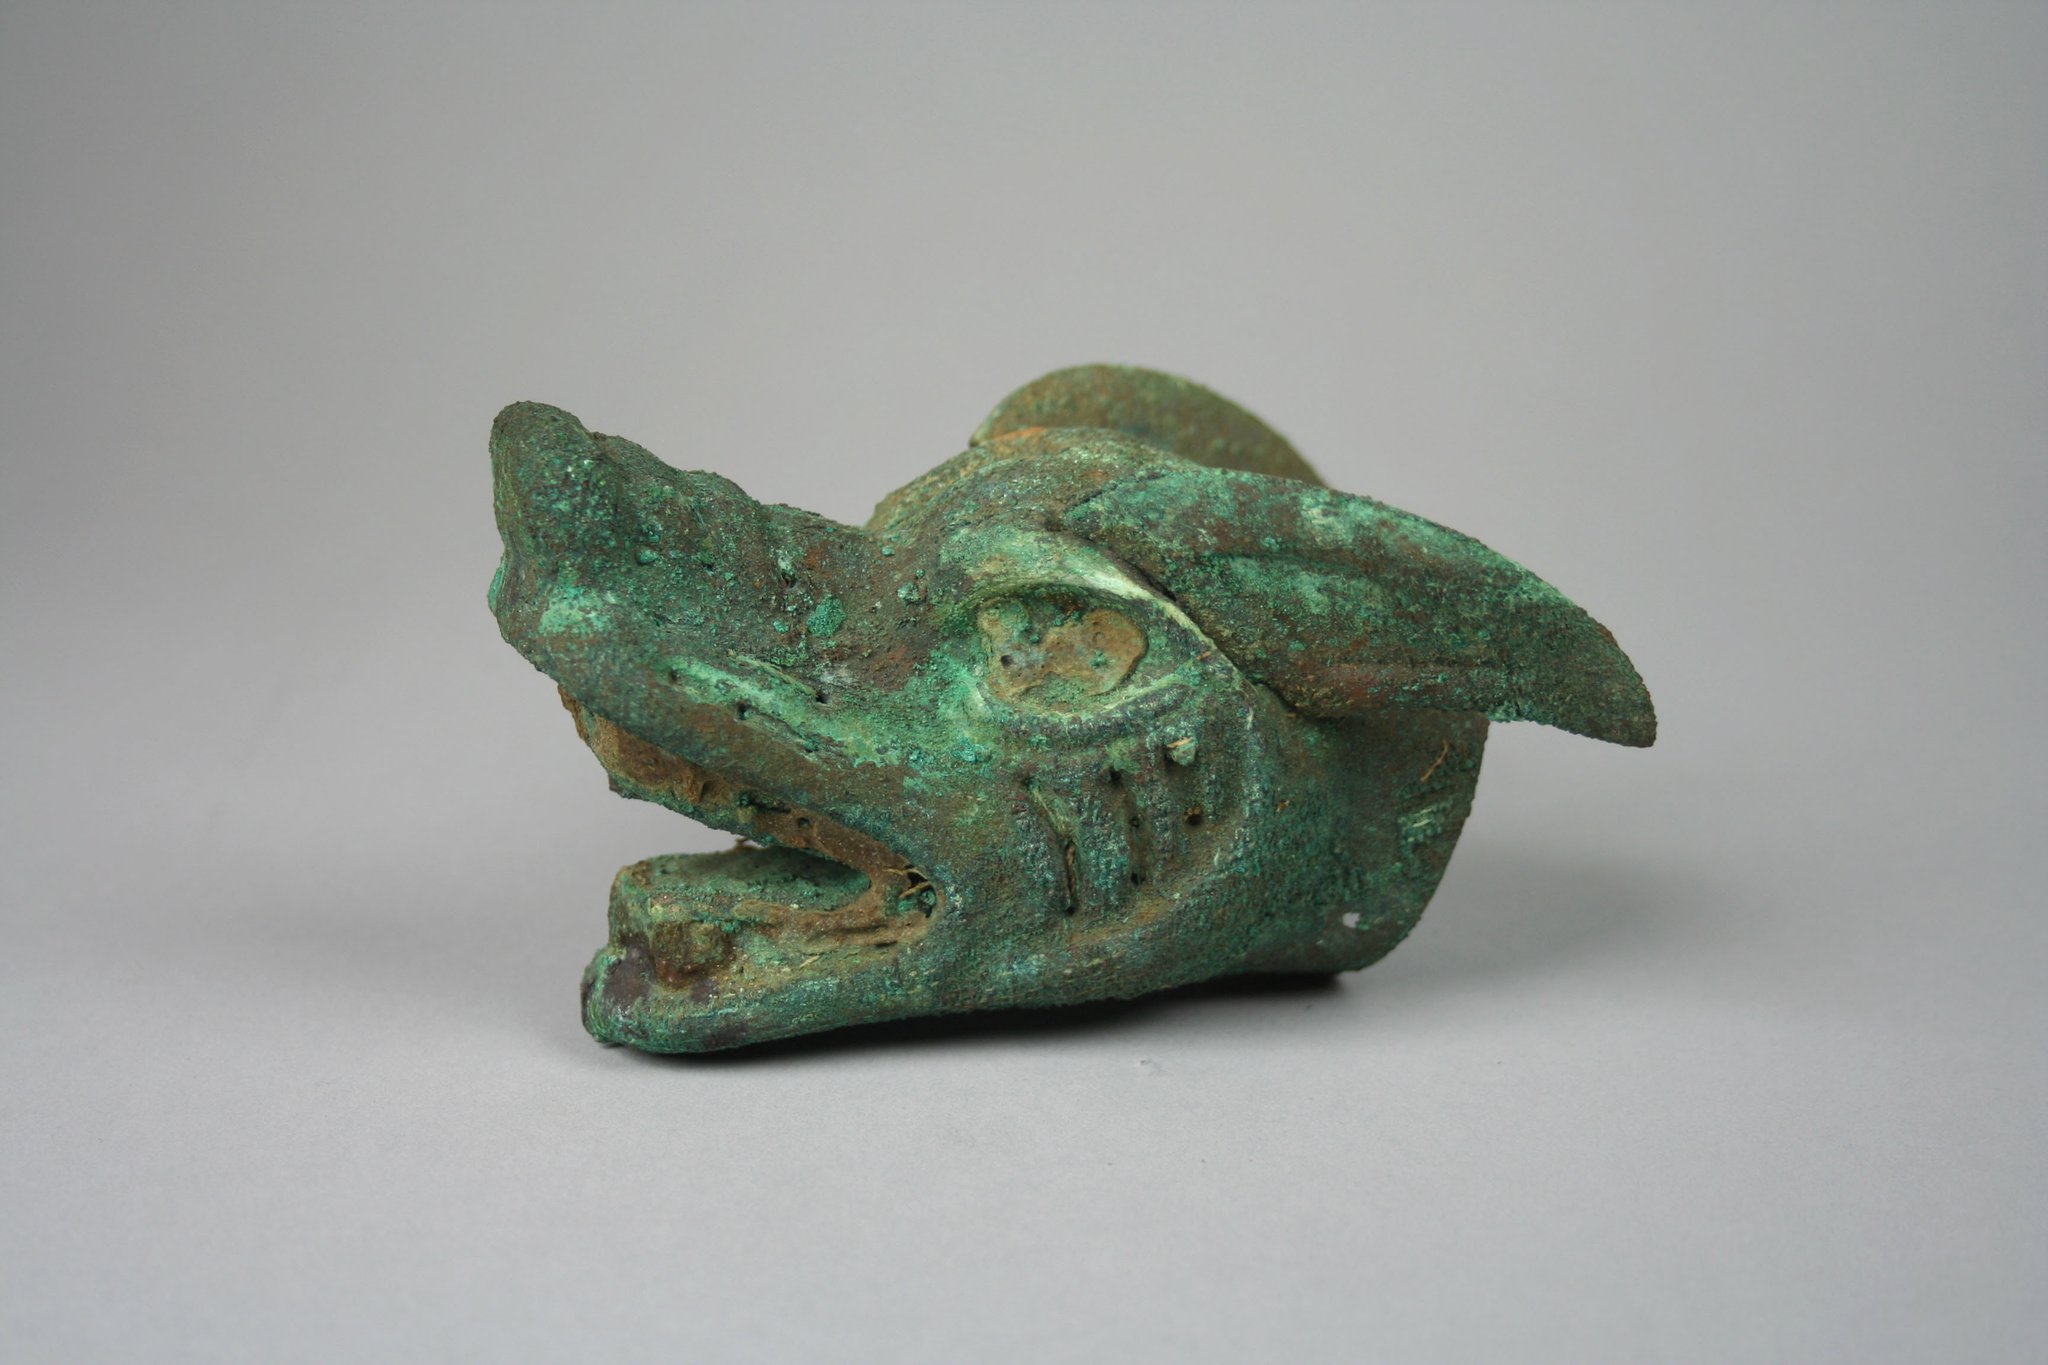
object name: ornament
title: Animal Ornament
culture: moche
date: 501-700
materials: gilt copper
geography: peru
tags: animals